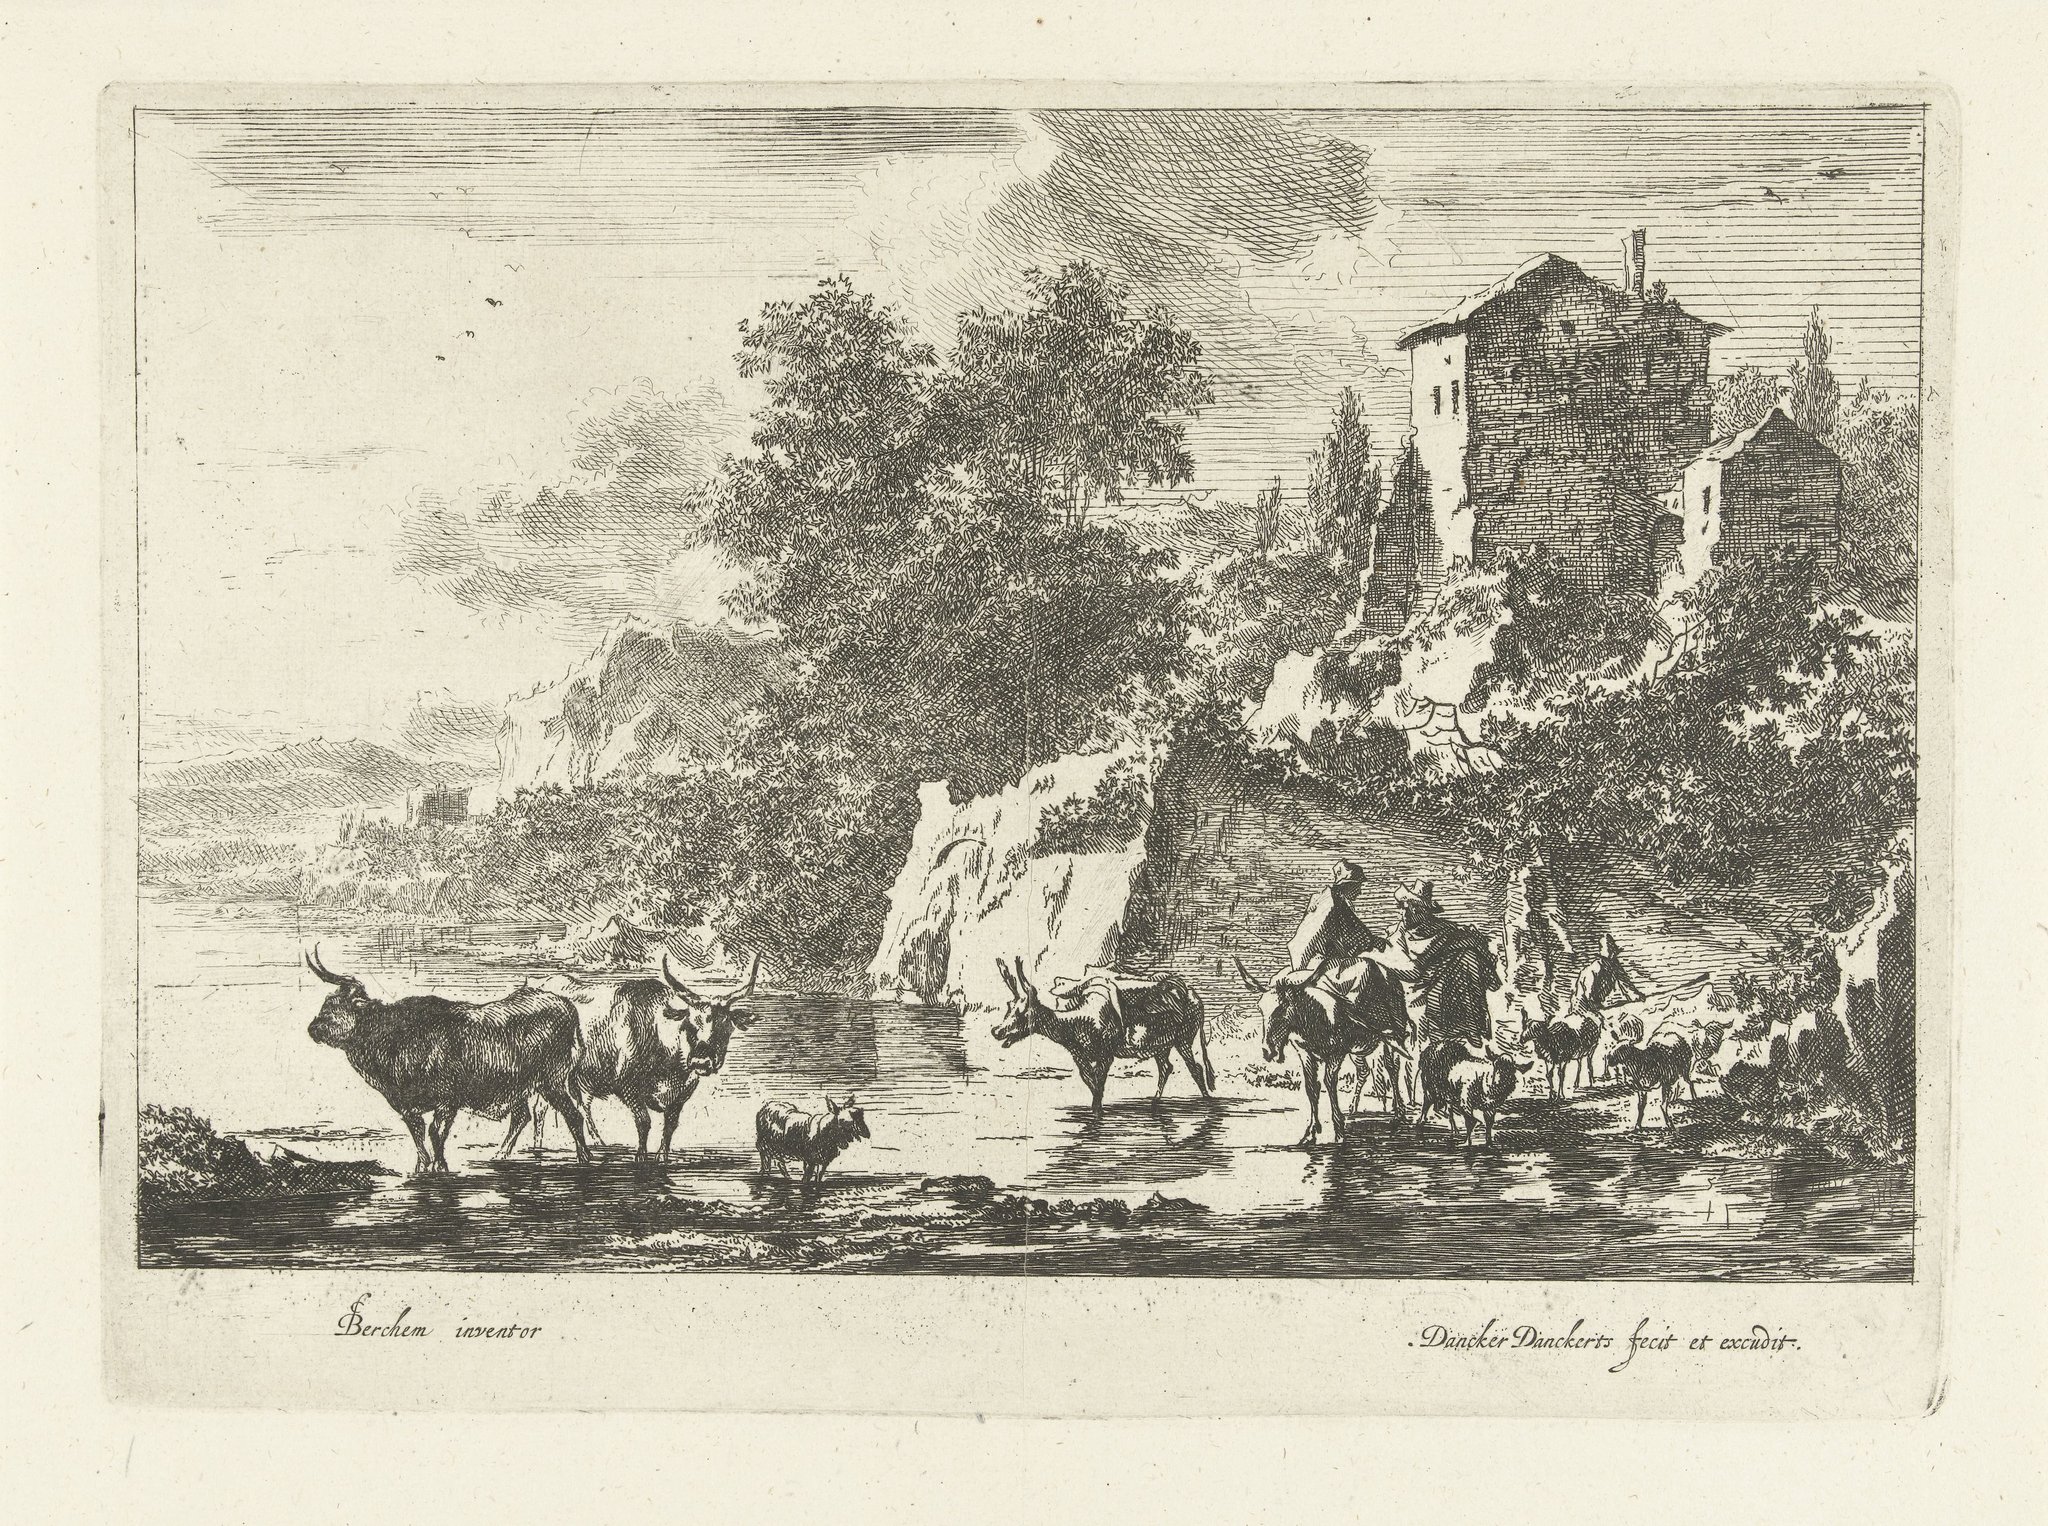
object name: print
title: Italiaanse landschappen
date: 1643-1666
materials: paper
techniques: etching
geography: amsterdam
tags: herding, herdsman, herdswoman, shepherd, shepherdess, cowherd, etc., rocks, herd, flock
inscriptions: collector's mark: Lugt 240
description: Italiaans landschap met herders en kudde met koeien en schapen en ezels in het ondiepe water. Prent uit serie van vier Italiaanse landschappen.